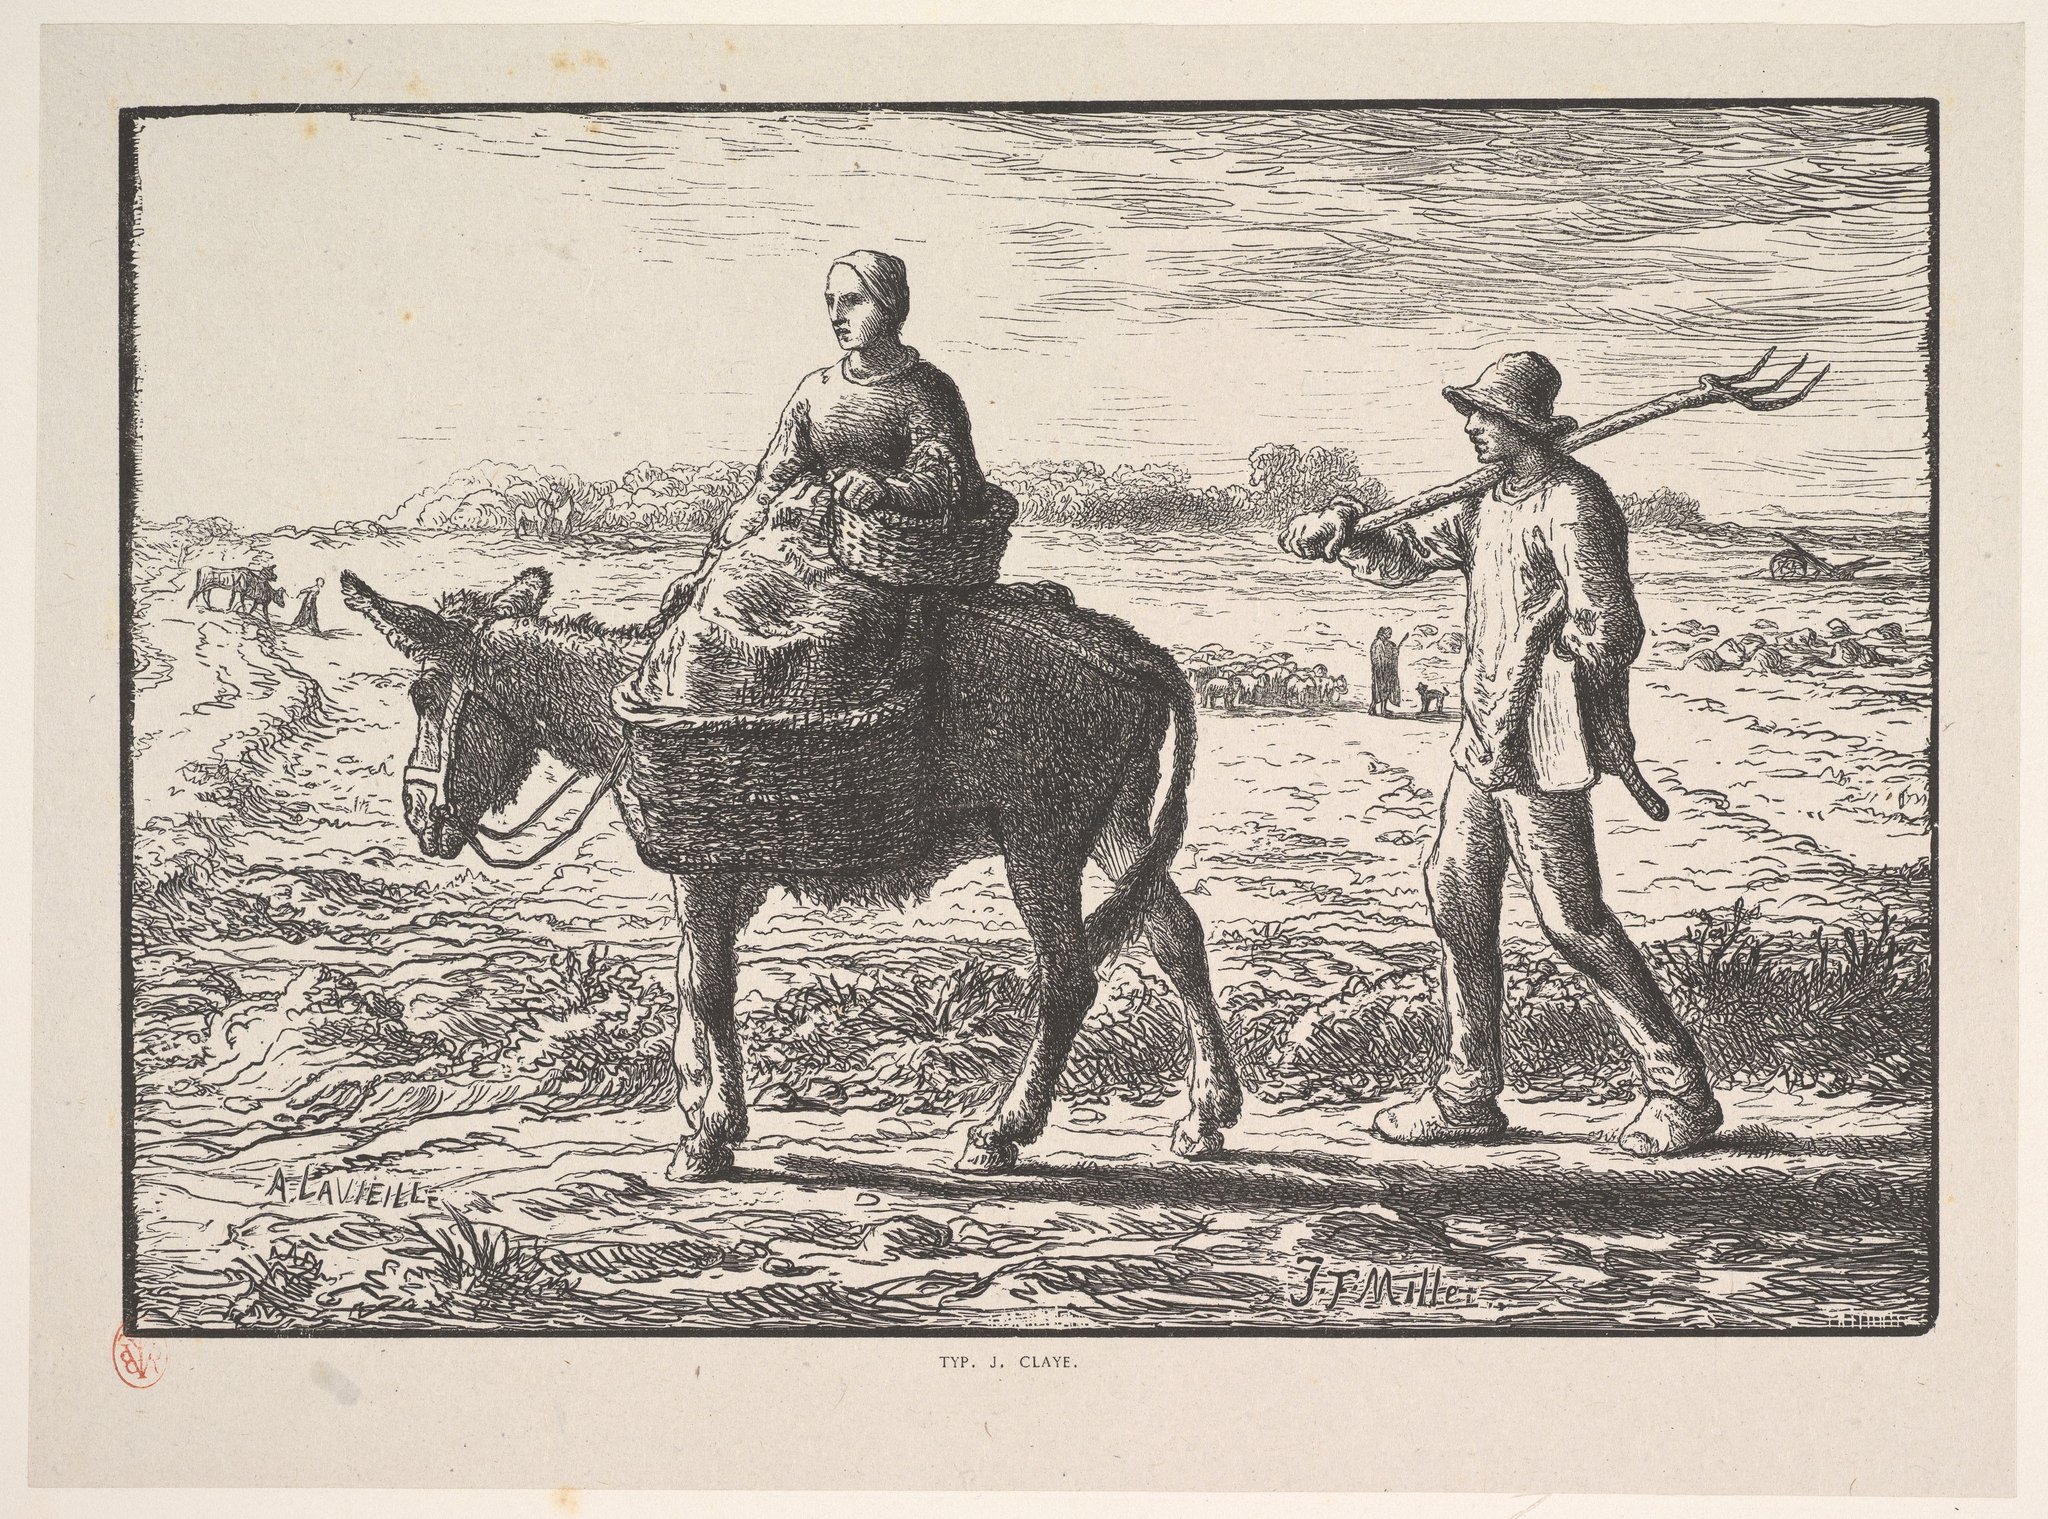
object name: print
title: Morning, from "Four Times of the Day"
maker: jean-françois millet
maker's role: artist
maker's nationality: french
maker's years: 1814-1875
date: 1830-1875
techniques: printmaking, engraving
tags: animals,men,women,morning